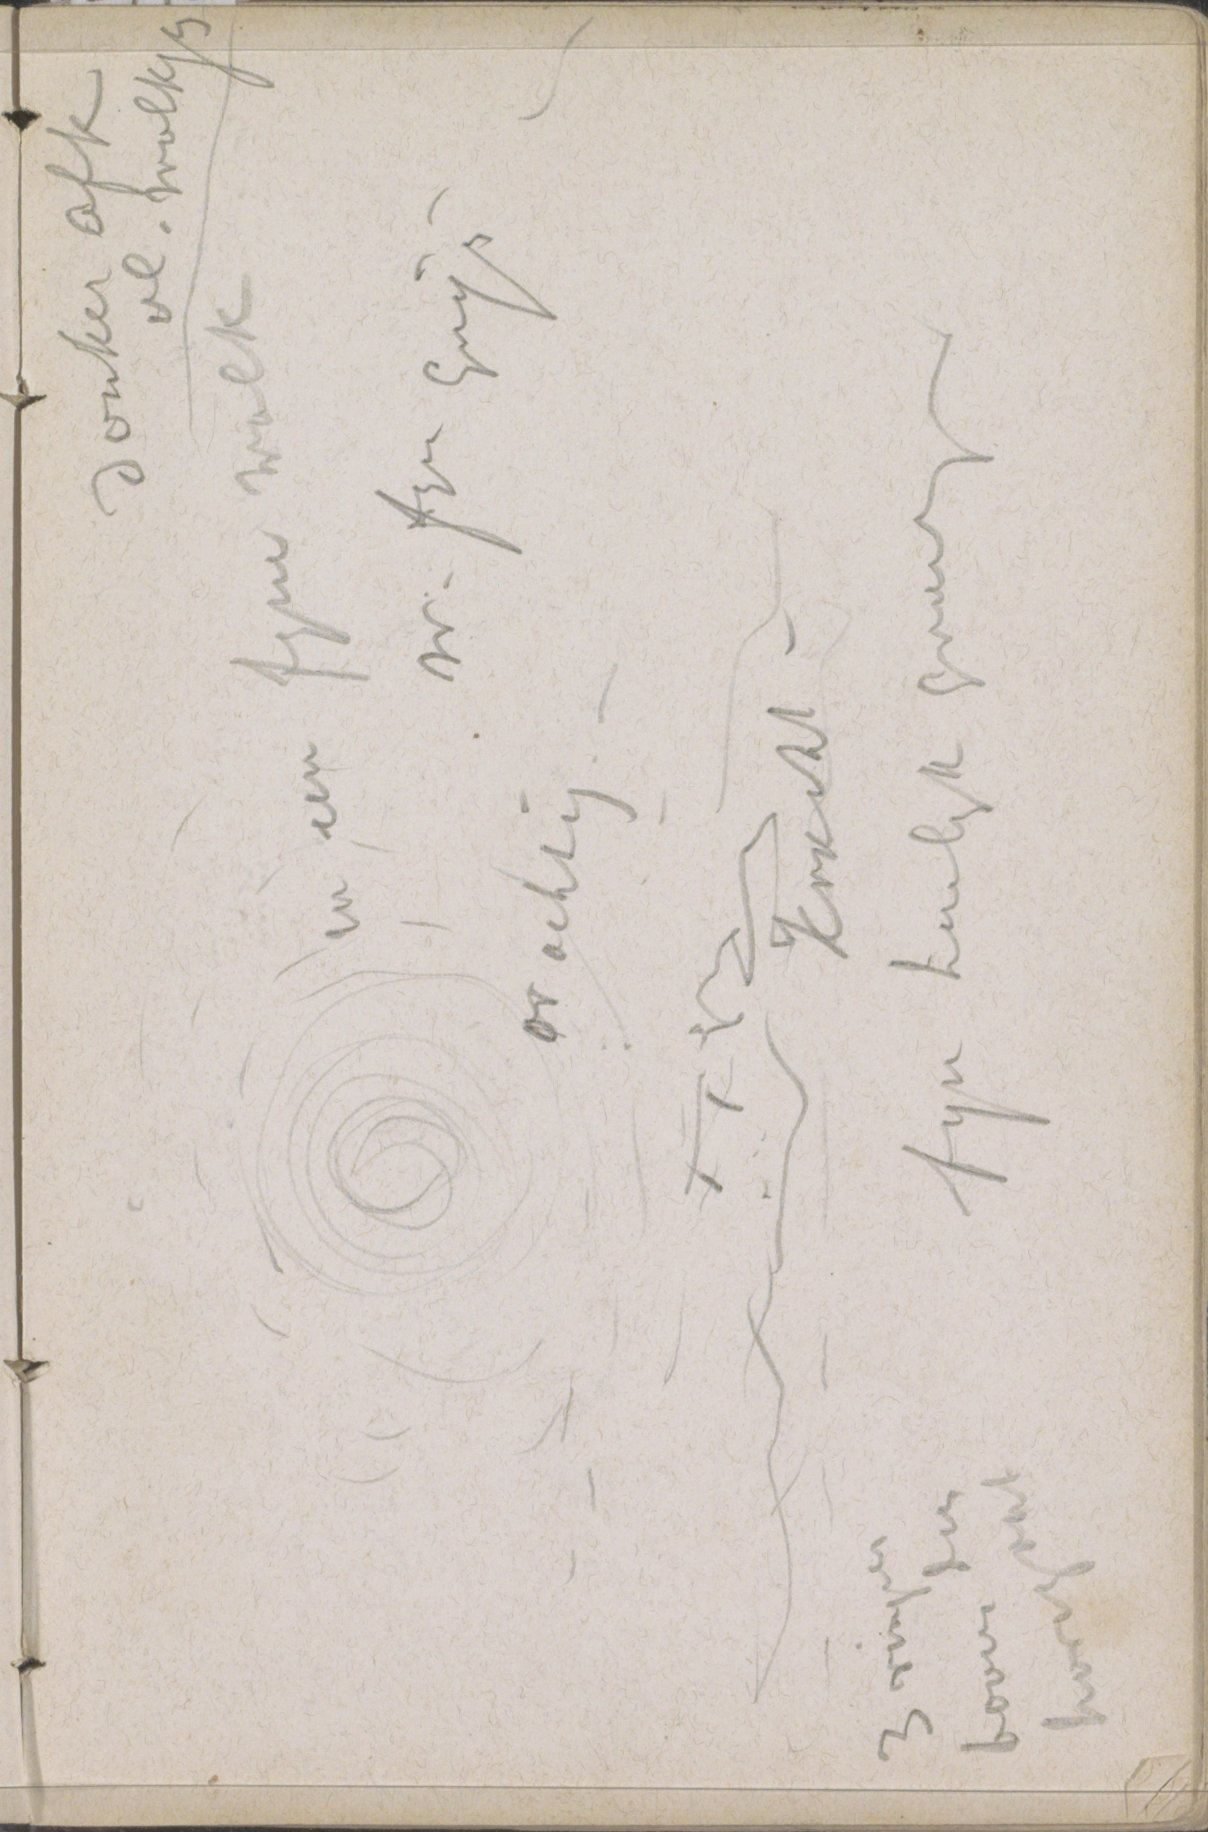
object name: sketchbook leaf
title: Zon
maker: johannes tavenraat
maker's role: draughtsman, painter, print maker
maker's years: 1809-1881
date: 1862-1864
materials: paper, pencil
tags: sun as celestial body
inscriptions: kleurnotitie, handgeschreven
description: Blad 20 recto uit een schetsboek met 65 bladen.